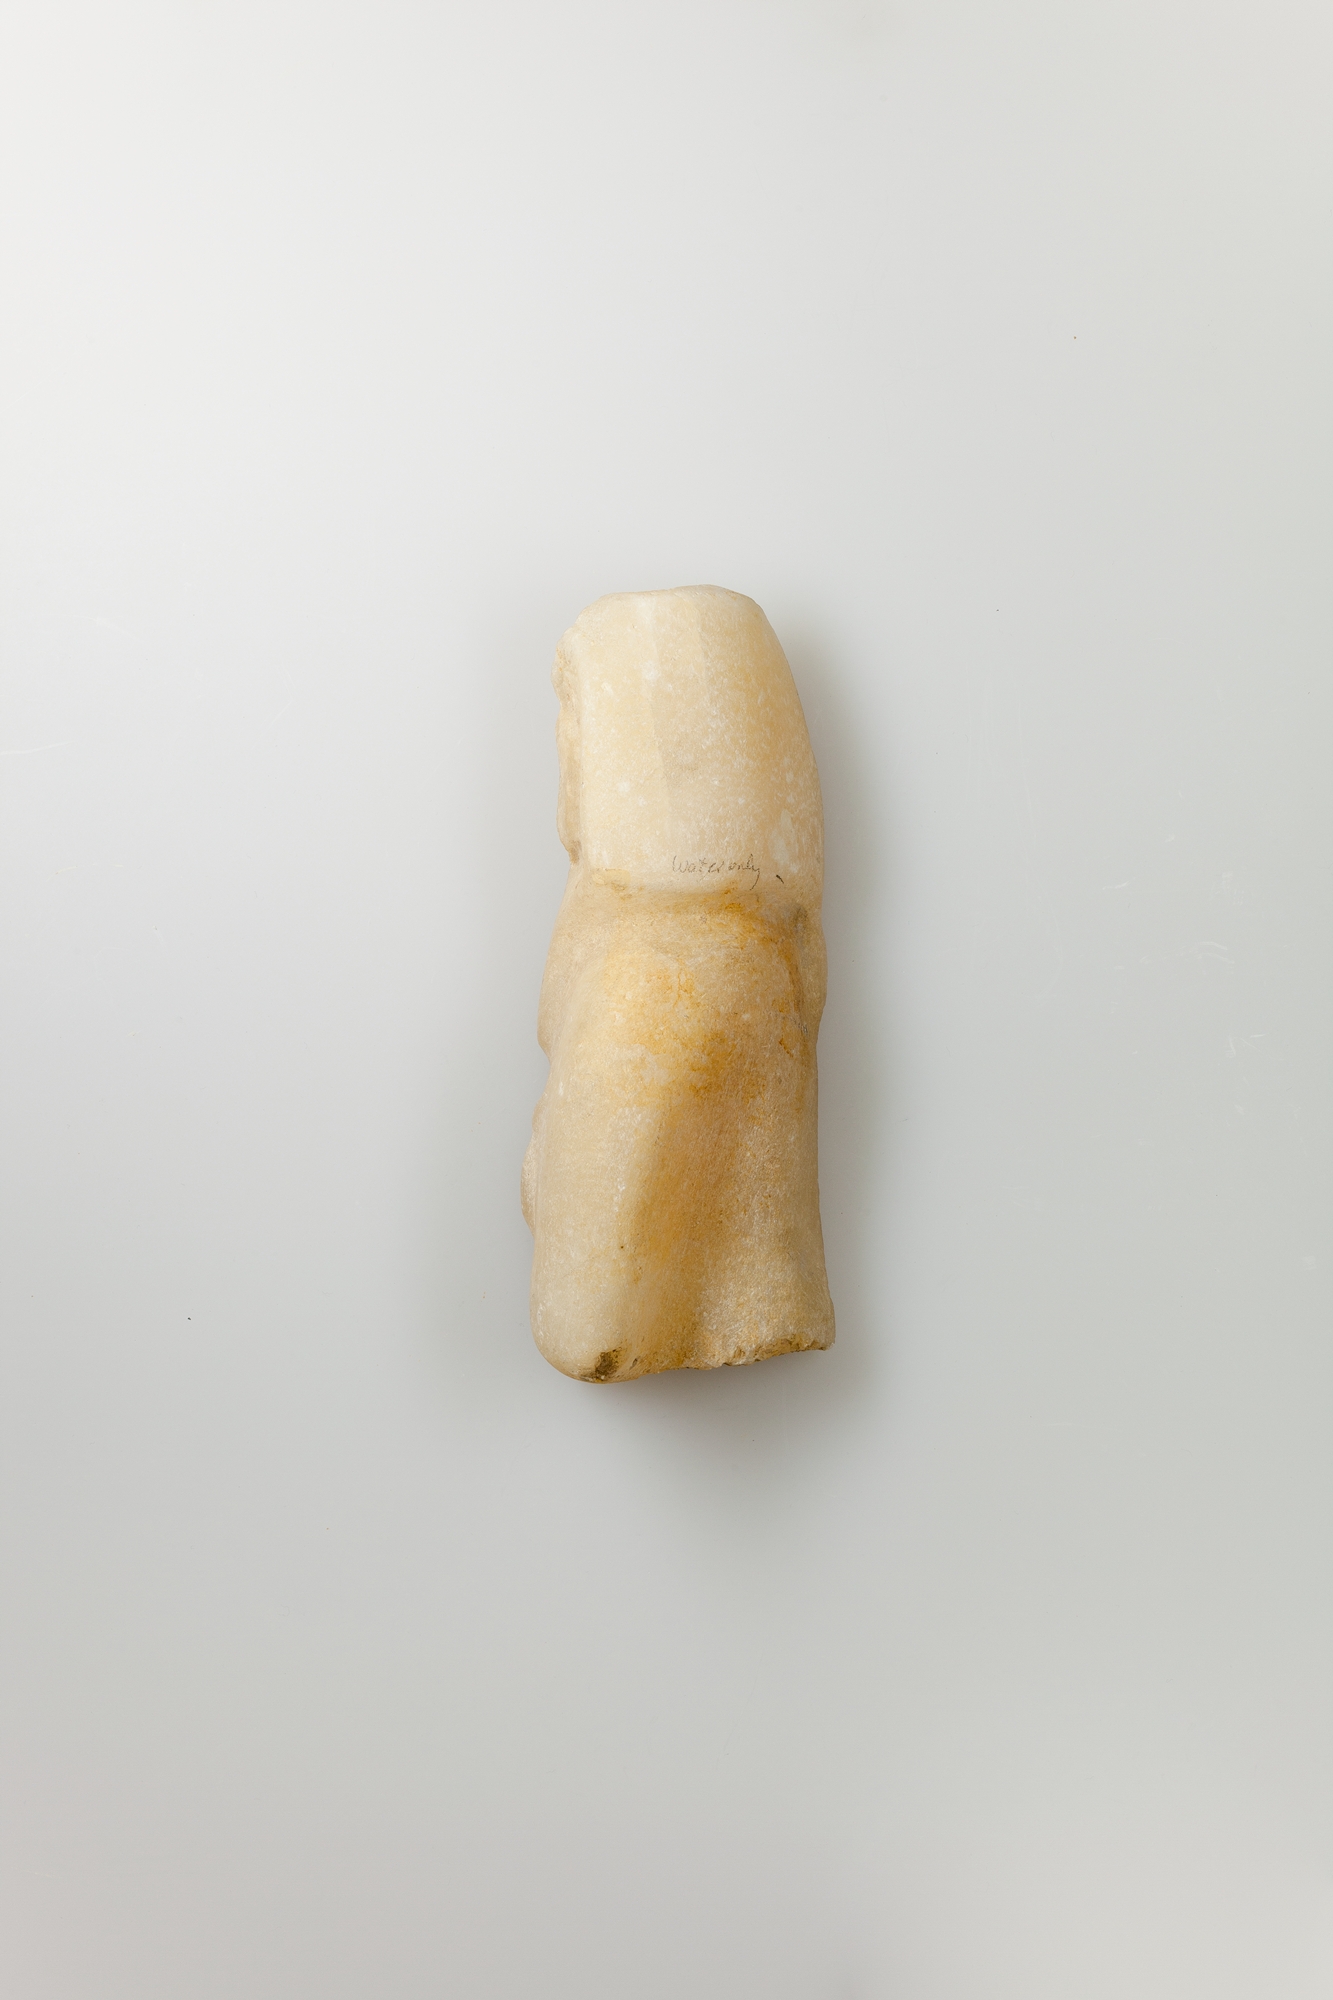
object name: shabti, siptah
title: Shabti of Siptah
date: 1194-1188 BCE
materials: stone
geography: egypt